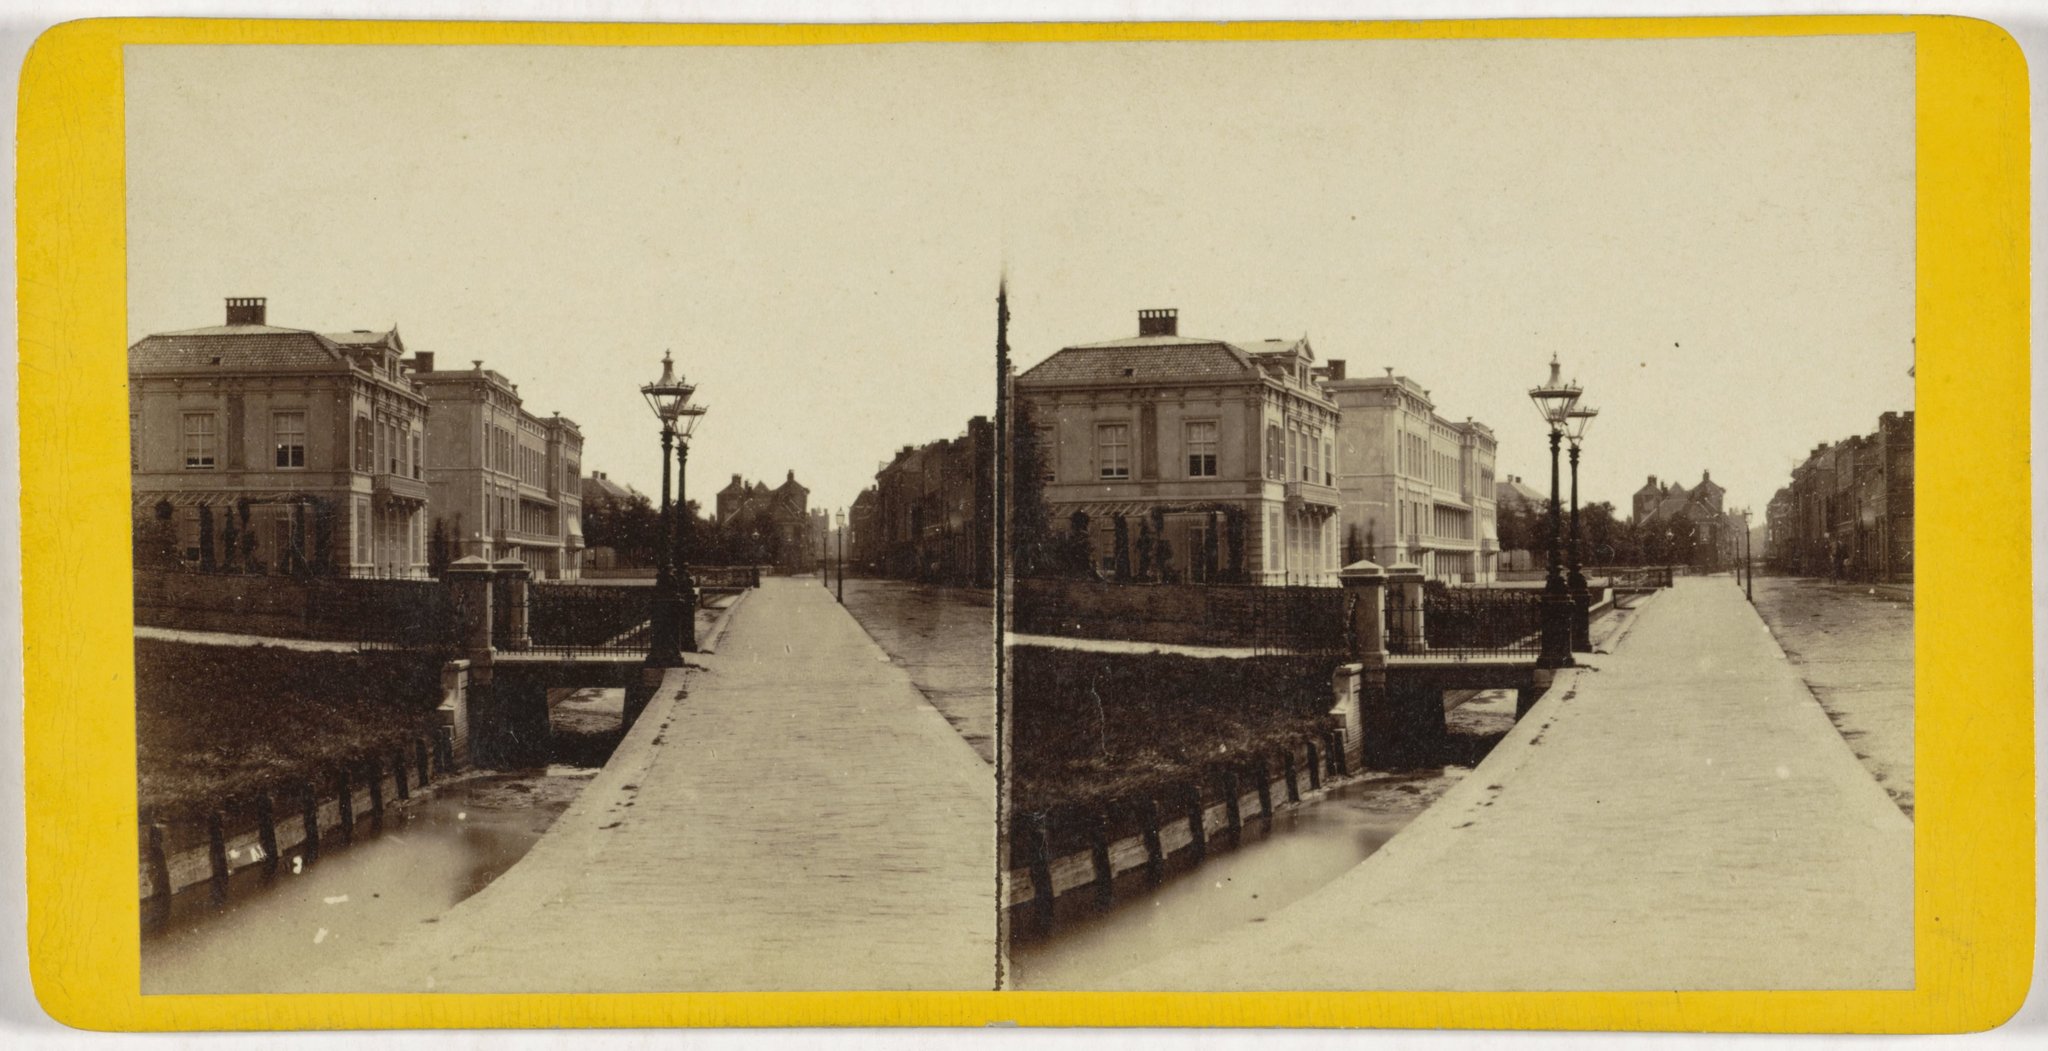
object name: stereograph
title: Gezicht op de Zeestraat gezien vanaf de Javastraat in Den Haag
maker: Anonymous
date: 1873-1890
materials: cardboard, paper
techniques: albumen print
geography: the hague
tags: canals, waters (in city), street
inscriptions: inscription: ‘(grote gebouw achteraan links is zogenaamde "rijkeluis hofje")’